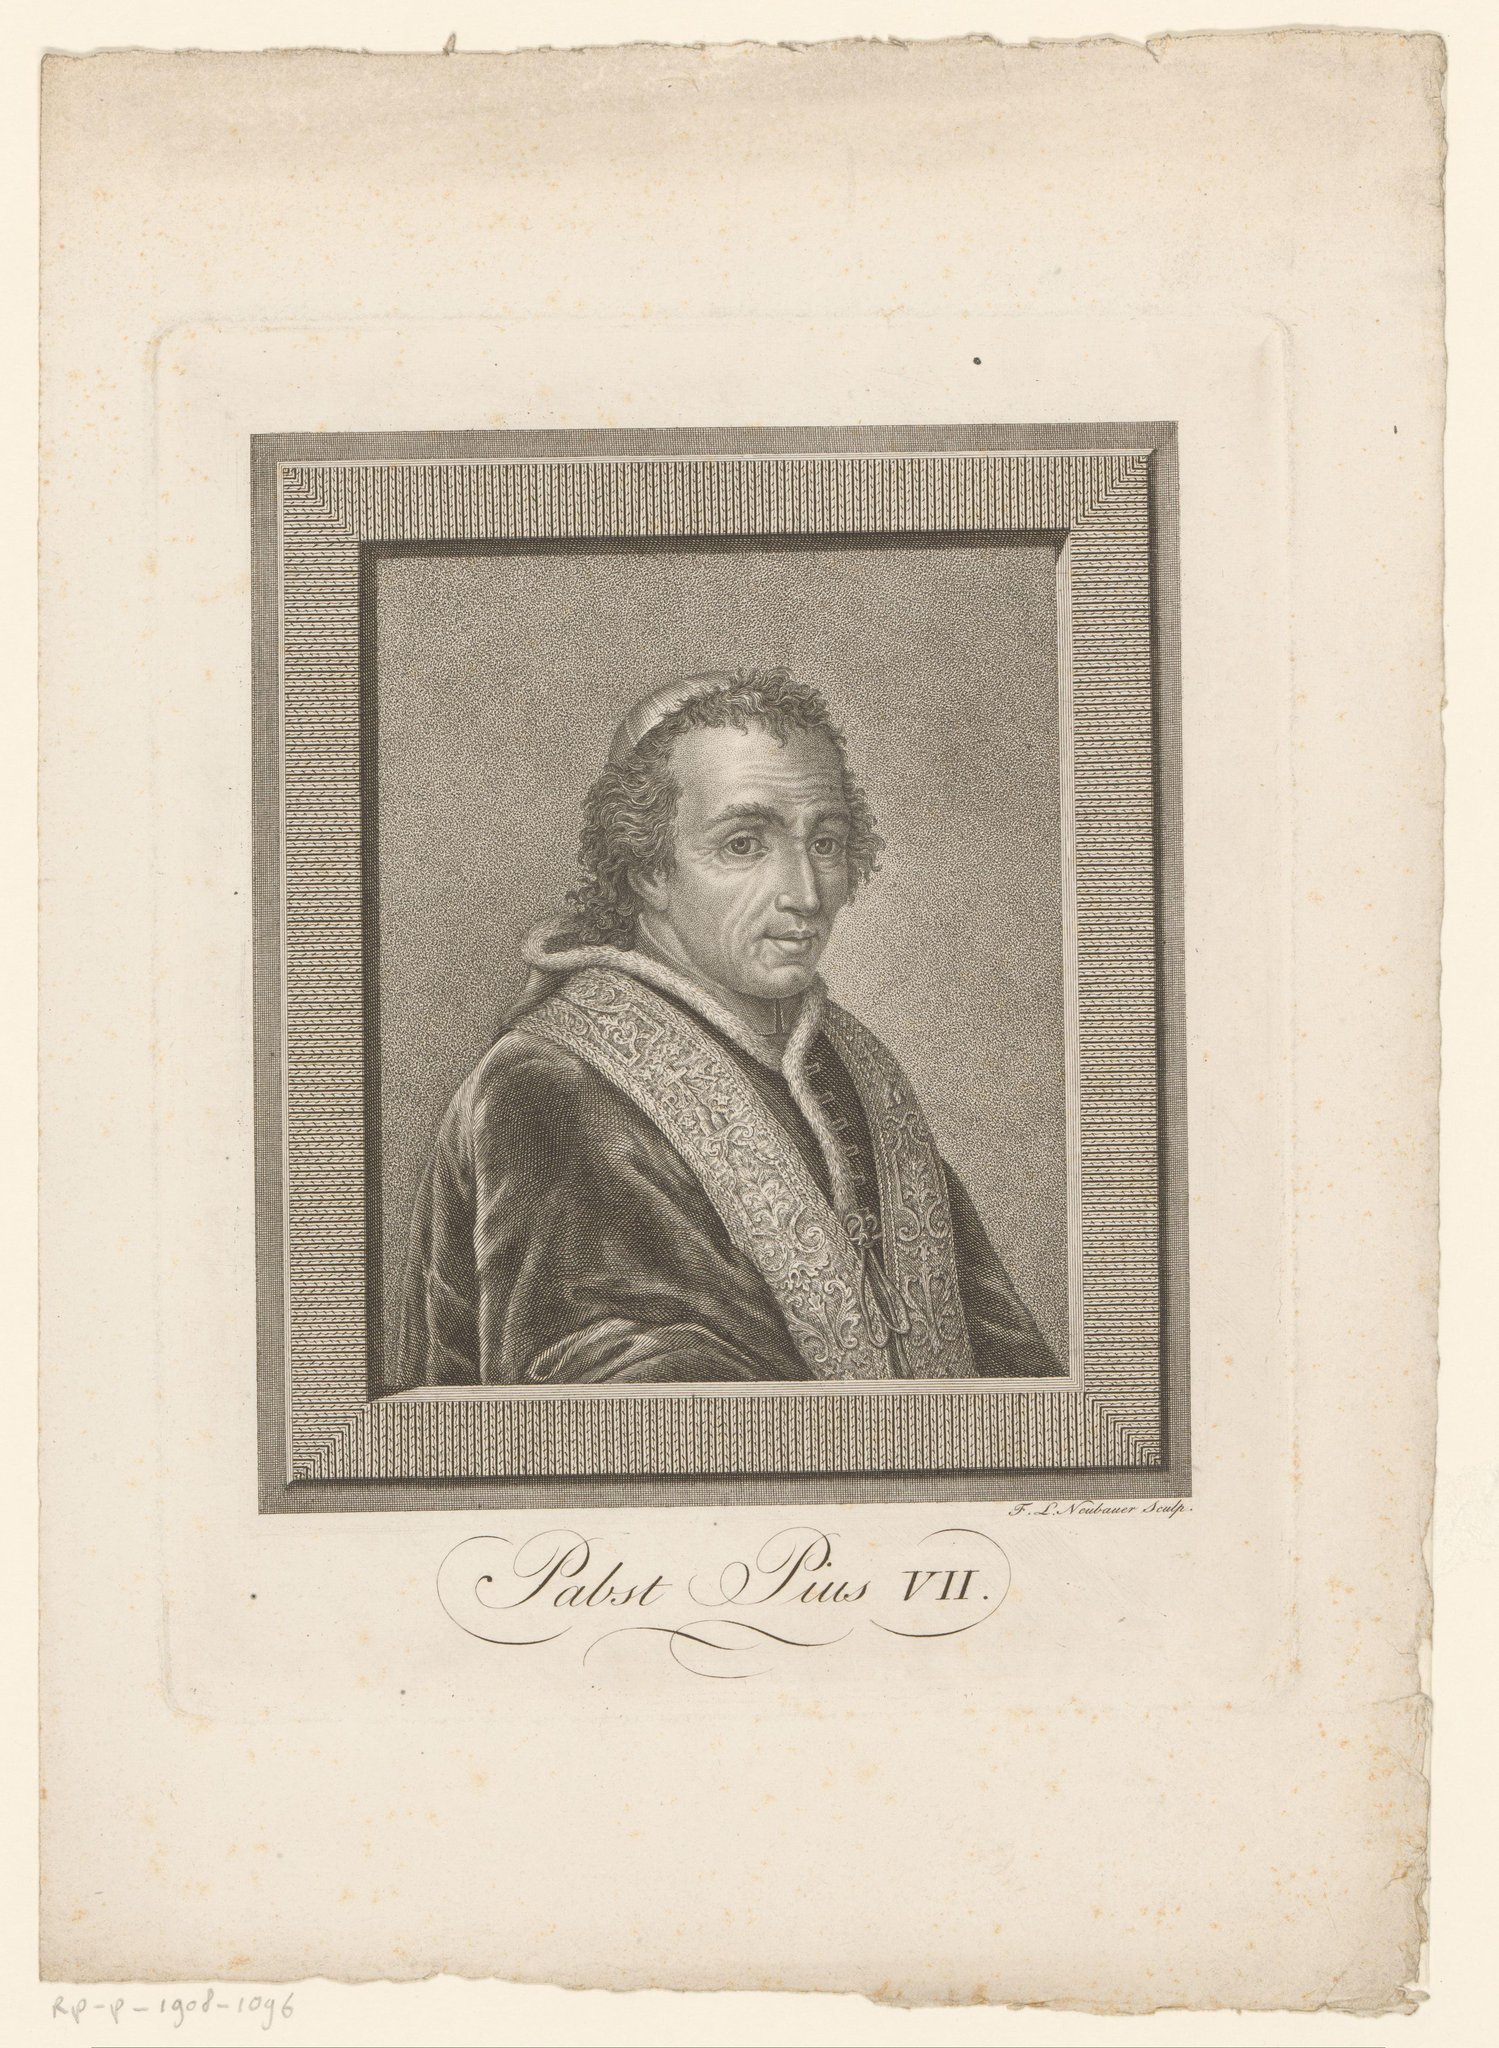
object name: print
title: Portret van Pius VII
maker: friedrich ludwig neubauer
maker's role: print maker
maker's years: 1767-1828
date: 1800-1828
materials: paper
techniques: etching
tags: rome, clergyman, pius vii, liturgical vestments, canonicals, historical persons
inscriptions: collector's mark: Lugt 2228